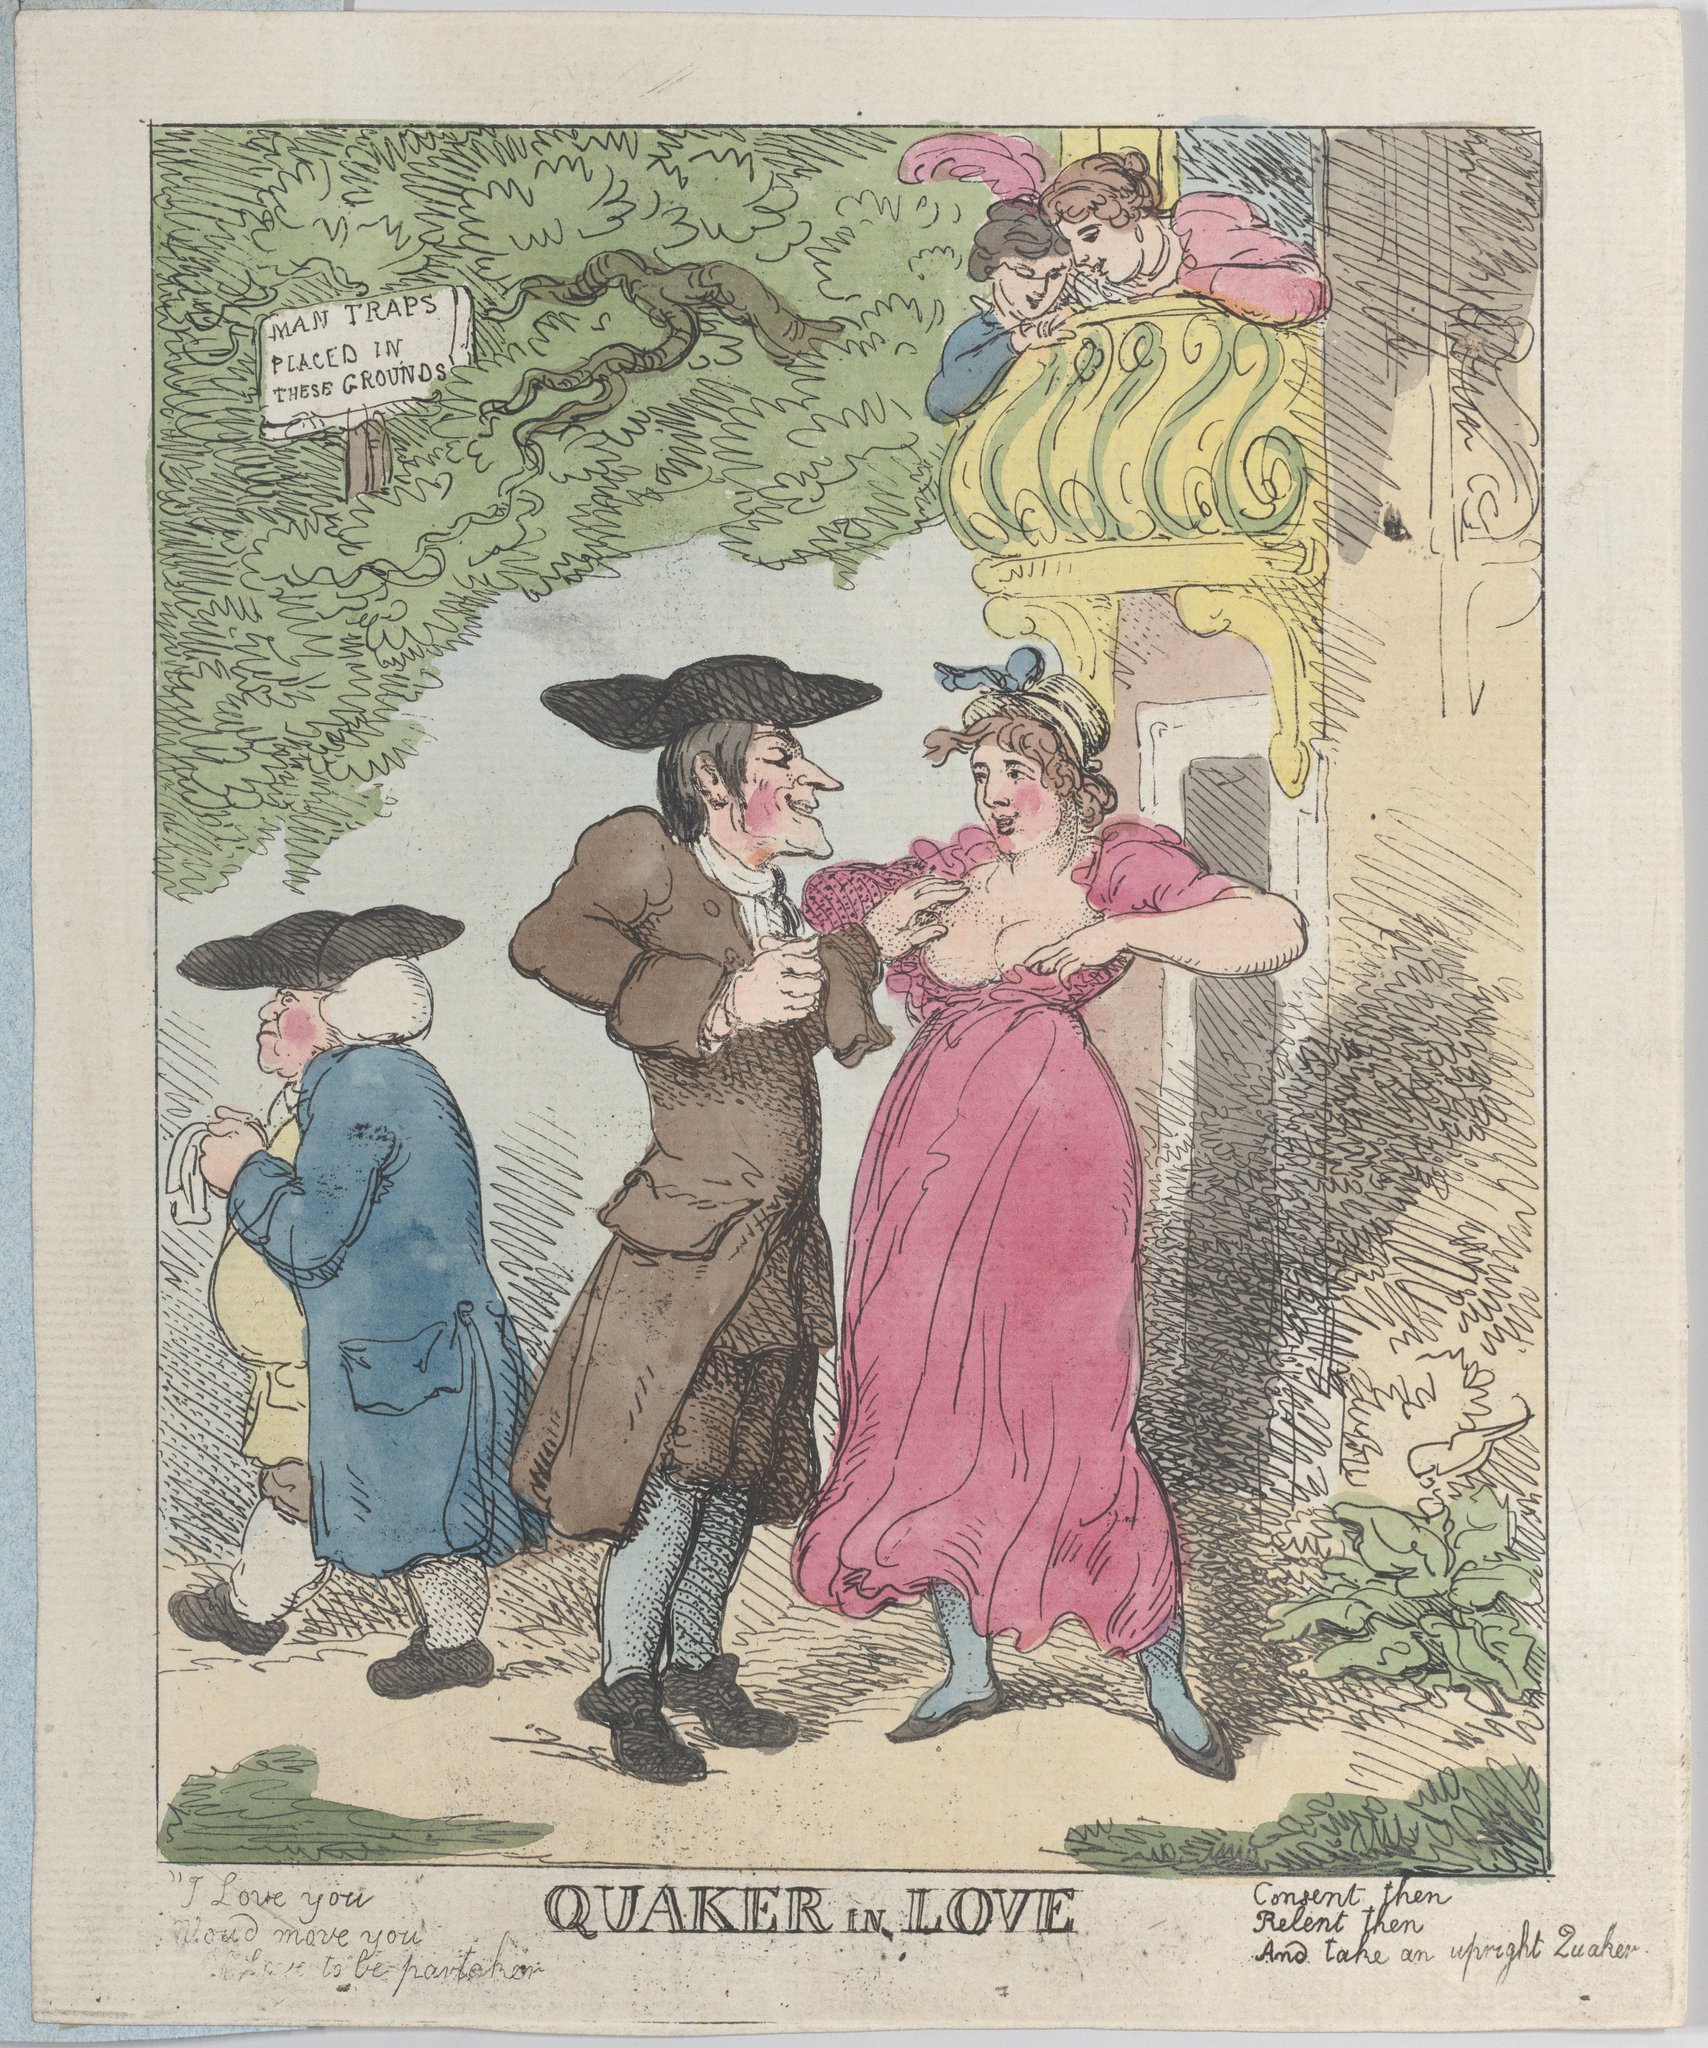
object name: print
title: Quaker in Love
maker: thomas rowlandson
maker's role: artist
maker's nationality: british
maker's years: 1757-1827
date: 1815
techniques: etching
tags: men,women